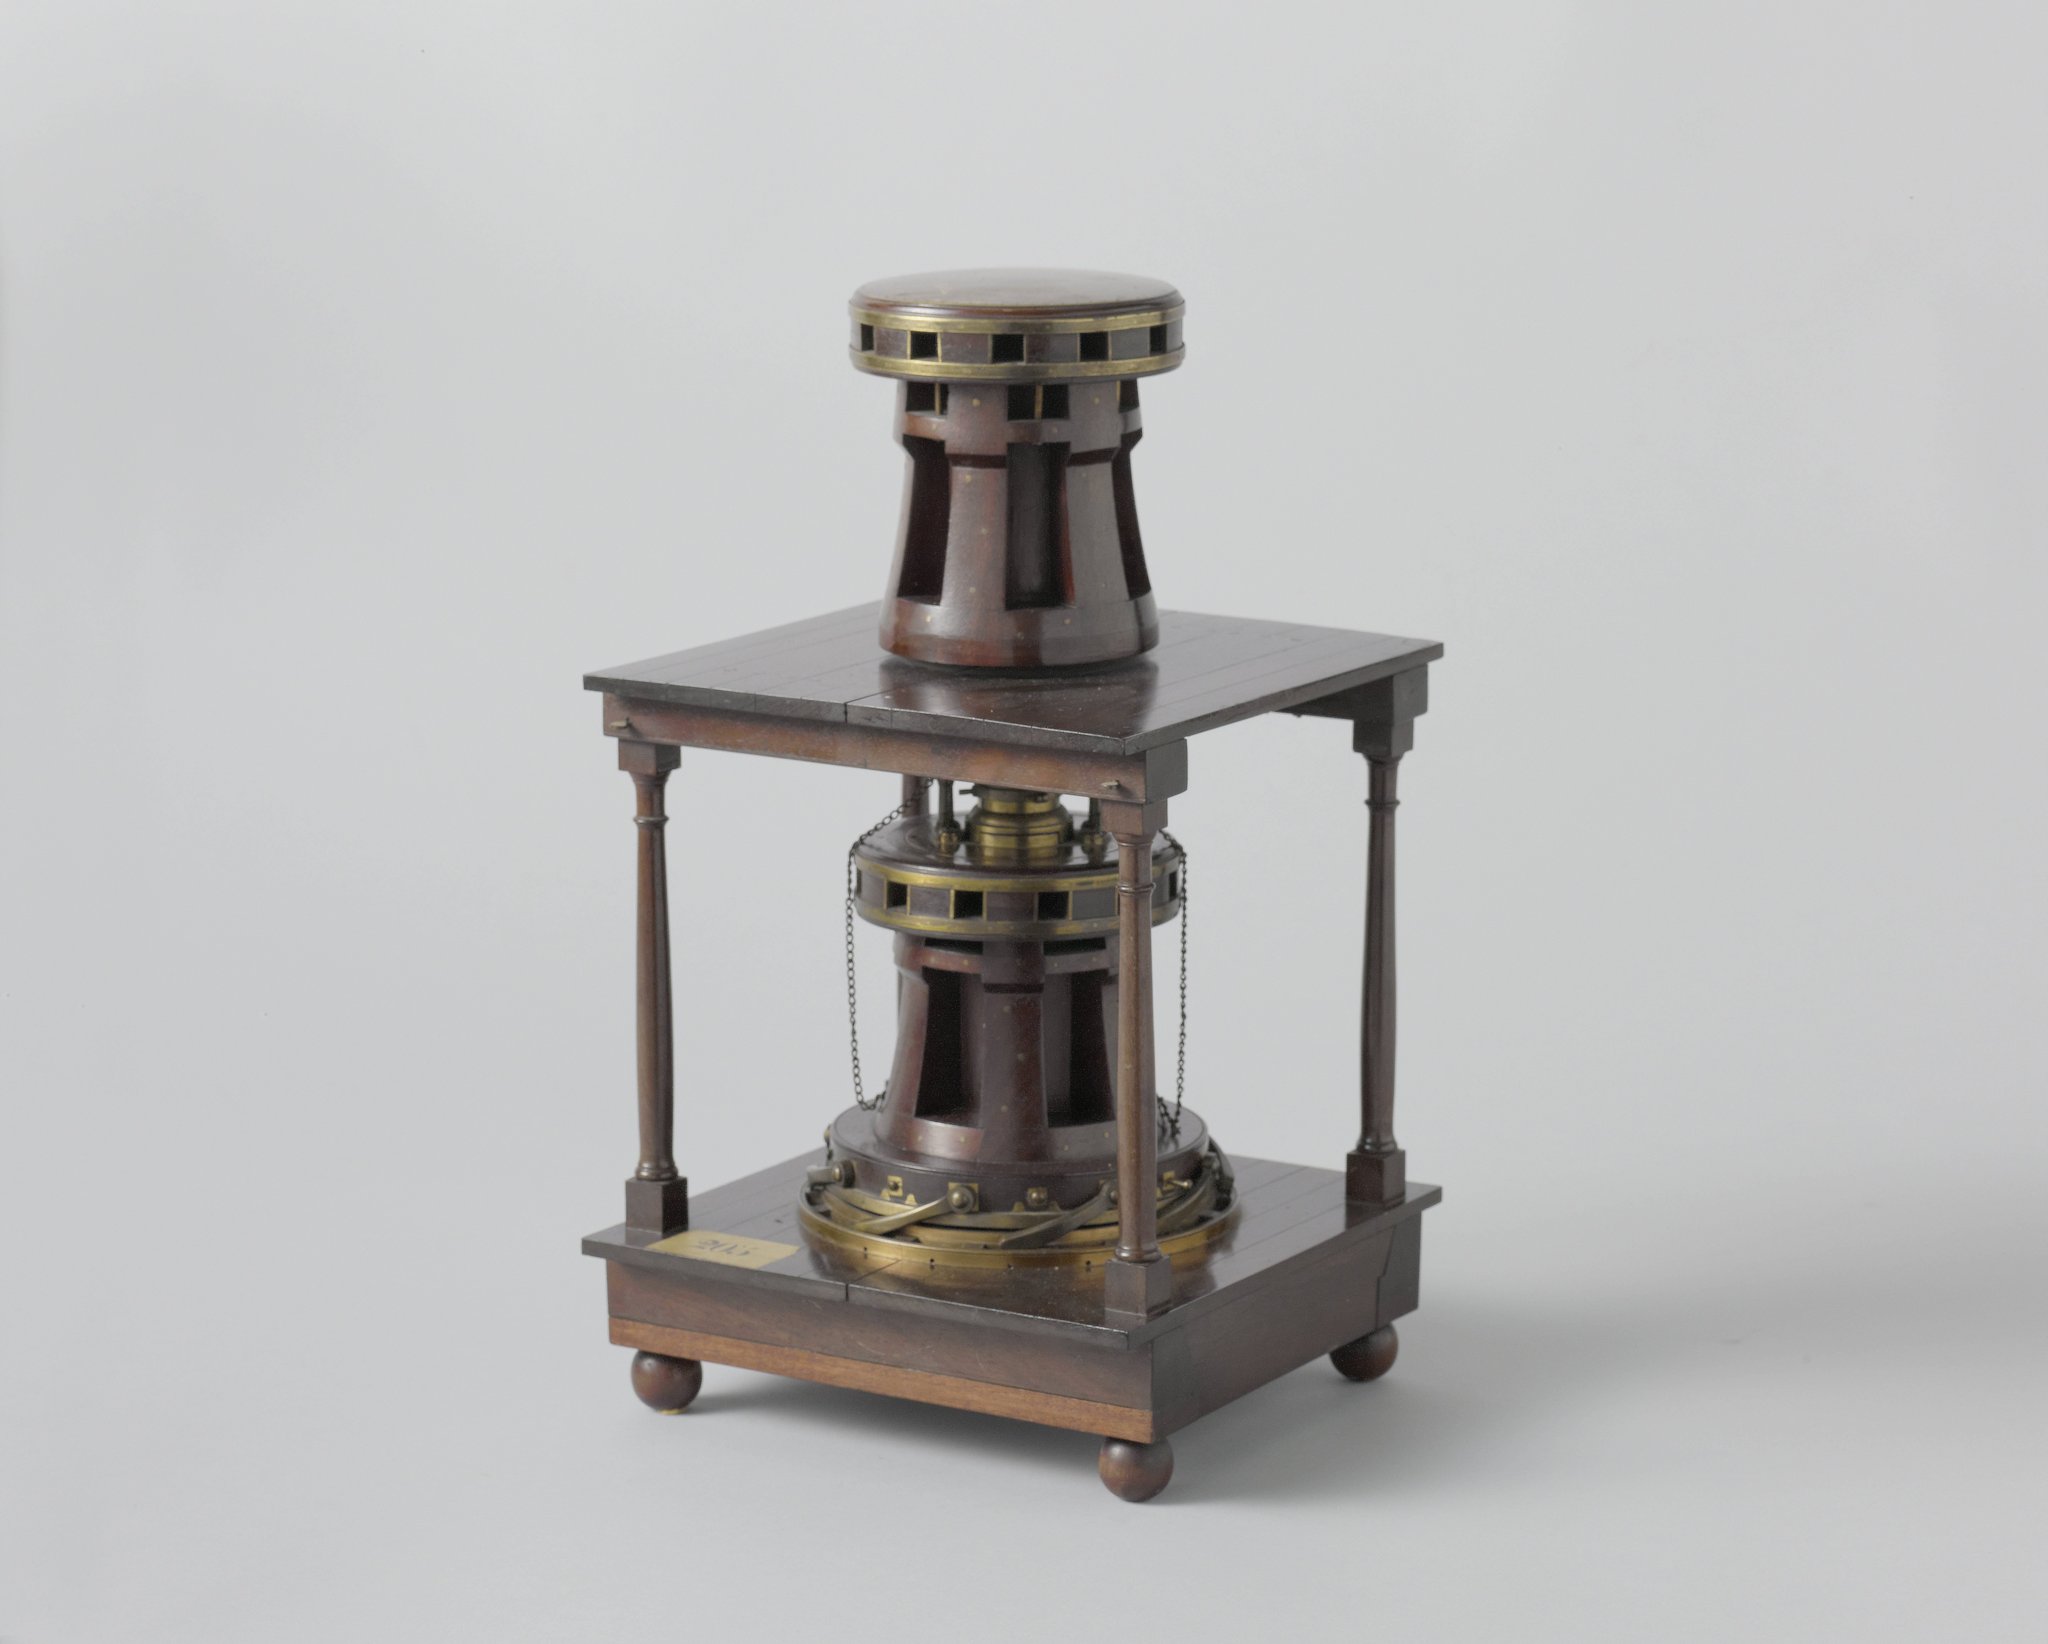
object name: demonstration model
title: Model of a Double Capstan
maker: Anonymous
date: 1820-1840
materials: brass, wood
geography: netherlands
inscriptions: label, on the lower deck: ‘205’ former inventory label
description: Model van een dubbele kaapstander in een houten frame dat twee dekken voorstelt. Beide kaapstanders zijn voor twaalf windbomen en hebben zes kiezen. De onderste trommel heeft acht pallen in de voet om teruglopen te voorkomen. De trommels kunnen op vier wijzen gebruikt worden: geblokkeerd, apart, gekoppeld, en gecombineerd zodat de bovenste de onderste met vertraging aandrijft. De combinaties worden verkregen met pallen in de voet van de onderste trommel, waarmee het raderwerk bestaande uit zon-en-planeetraderen, onder het onderdek tussen de balken geplaatst, in werking kan worden gesteld, en door het koppelen of ontkoppelen van de koningen van beide trommels met een mechaniek op de kop van de onderste kaapstander, dat nu incompleet is. Schaal 1:10 (schatting).